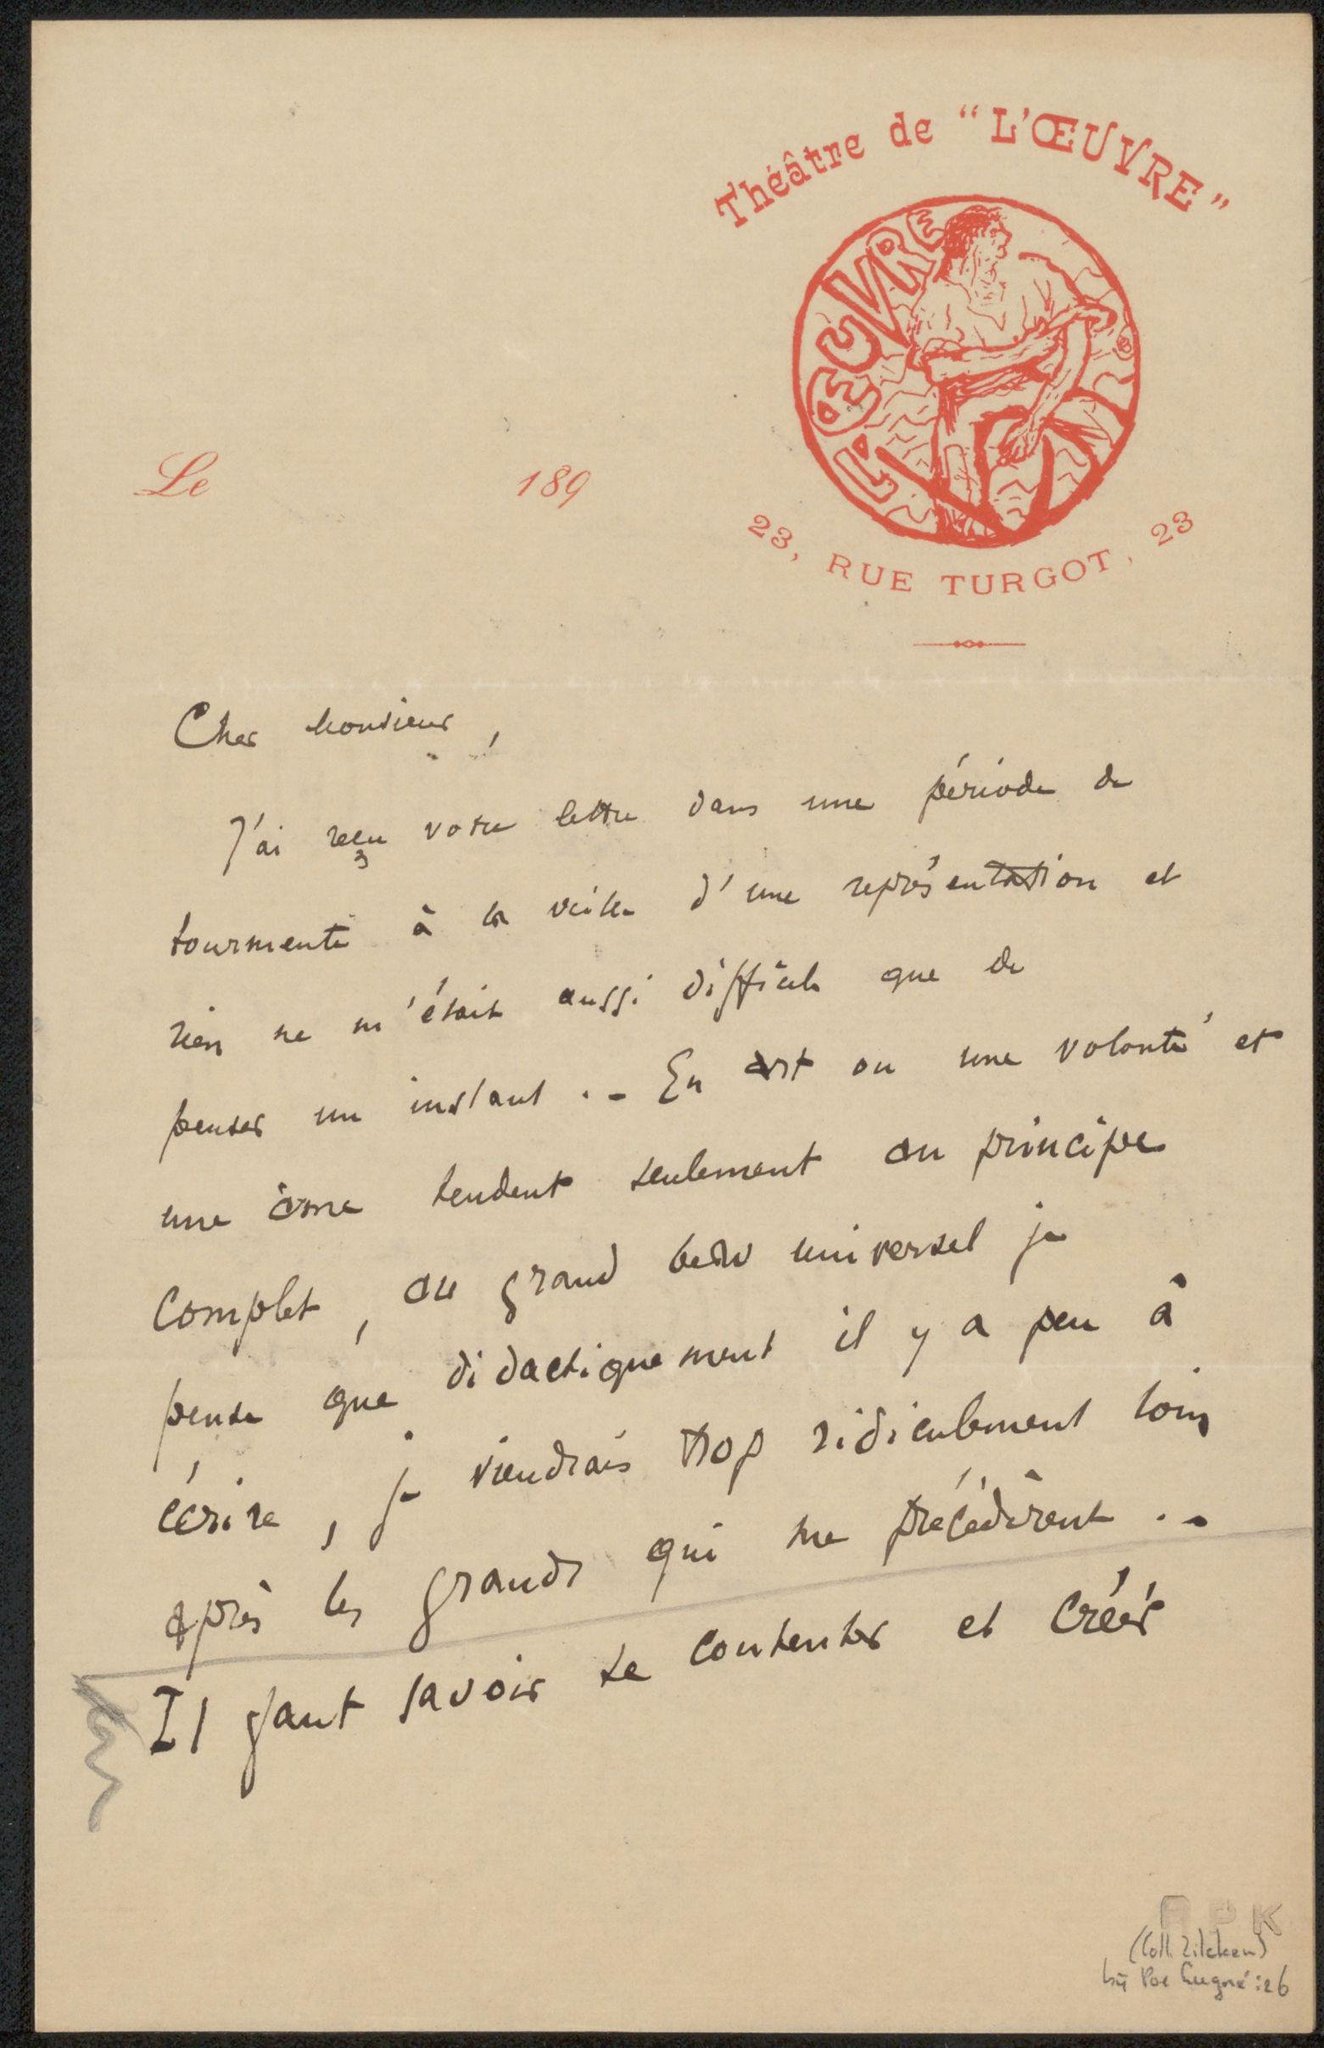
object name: letter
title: Brief aan Philip Zilcken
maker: lugné-poe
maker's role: acteur, theaterdirecteur, theatervormgever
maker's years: 1869-1940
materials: ink, paper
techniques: pen, printing, writing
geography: paris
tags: the hague, painter, draughtsman, philip zilcken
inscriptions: collector's mark: ‘RPK’, watermark